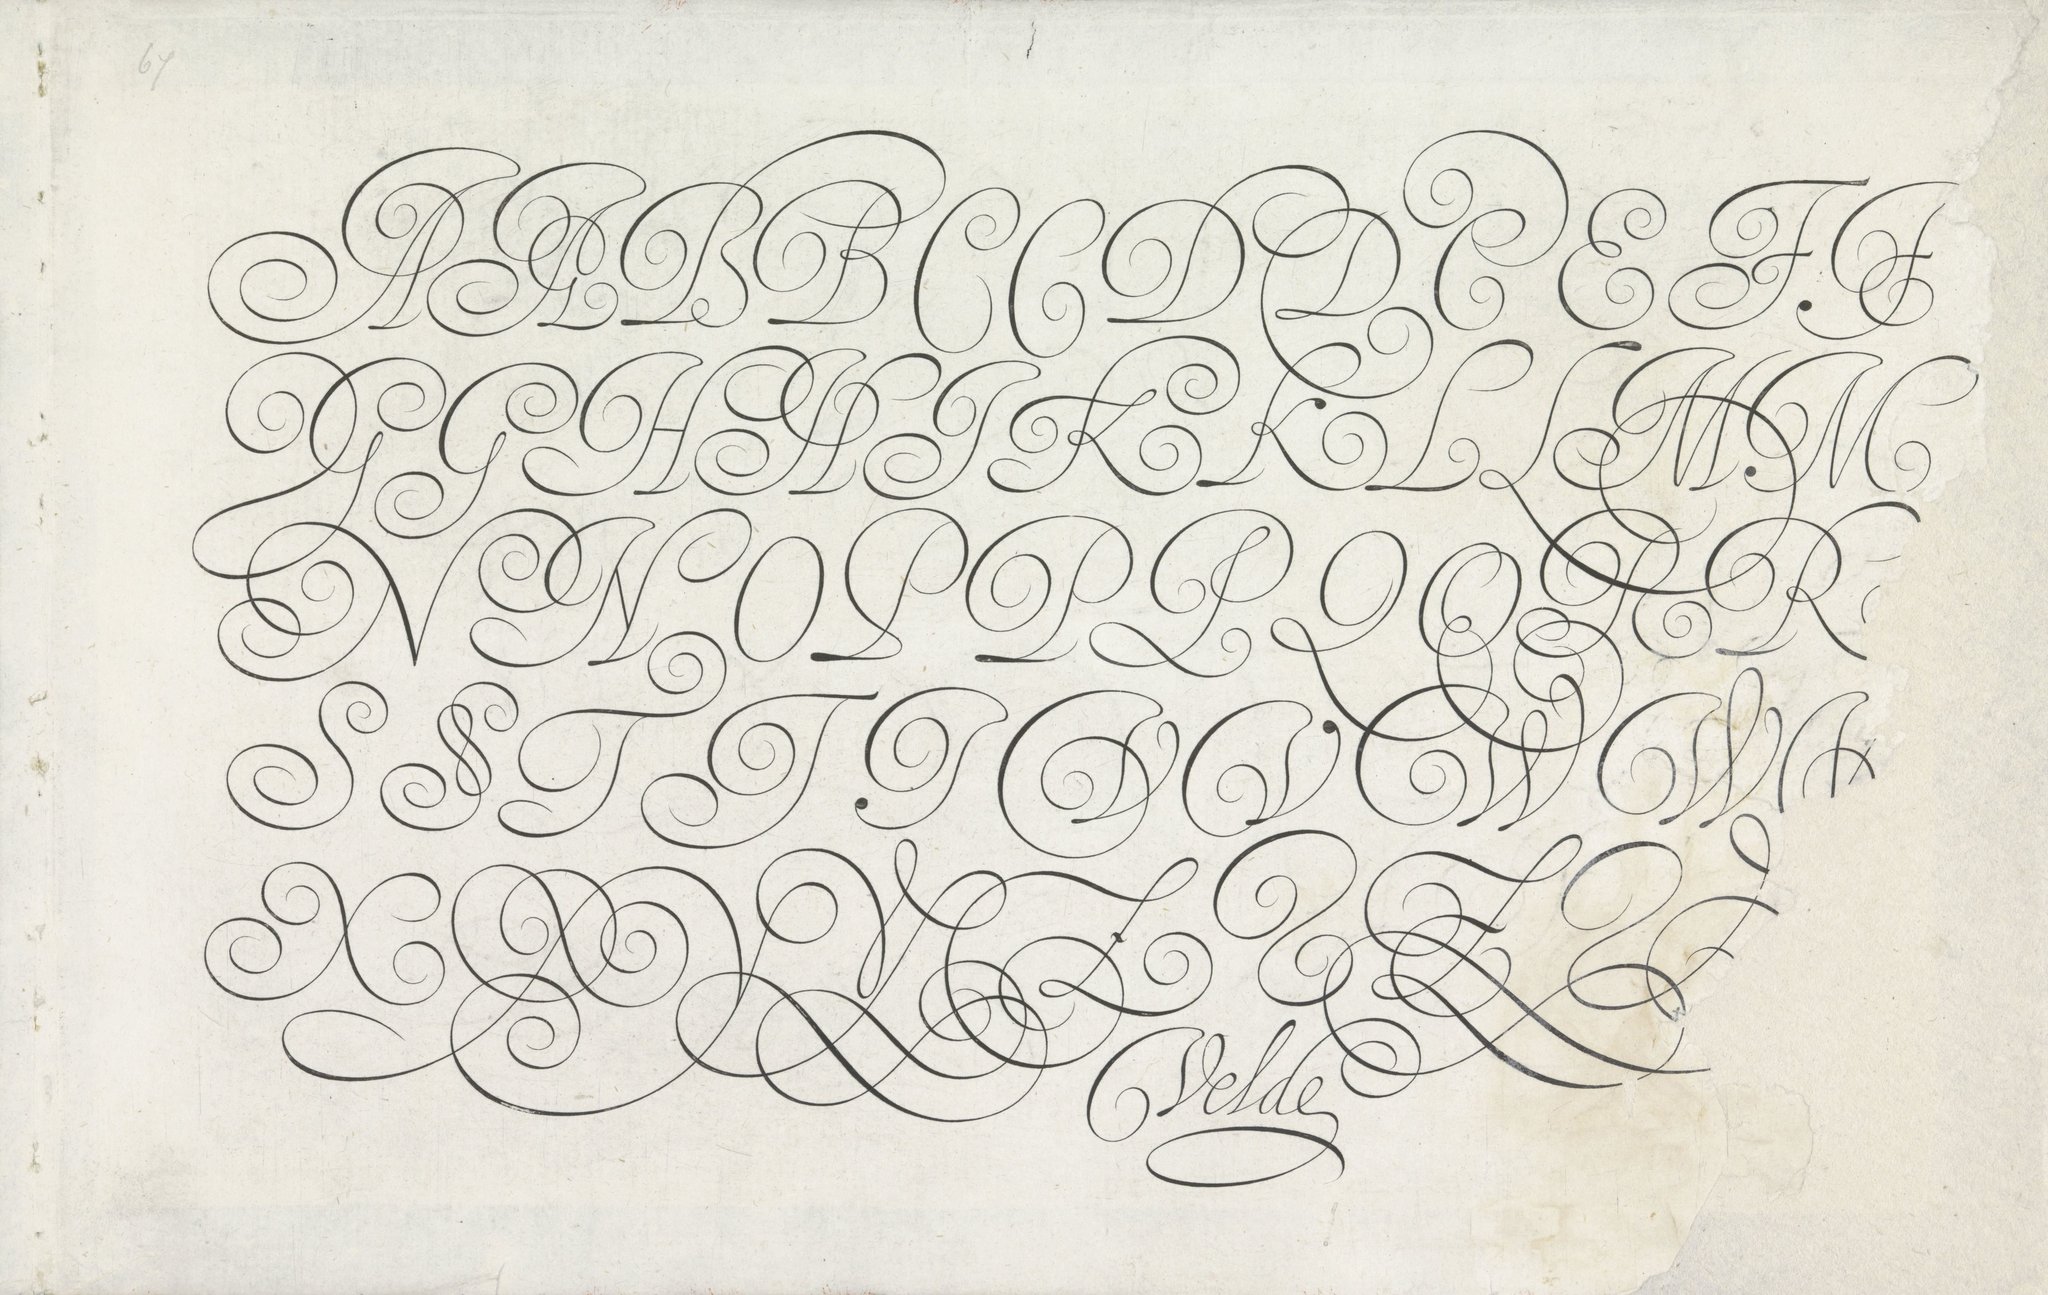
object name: print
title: Spieghel der schrijfkonste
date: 1605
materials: paper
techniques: engraving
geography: rotterdam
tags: calligraphy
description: Schrijfvoorbeeld met het alfabet in vijf regels kapitalen. De prent maakt deel uit van een album.